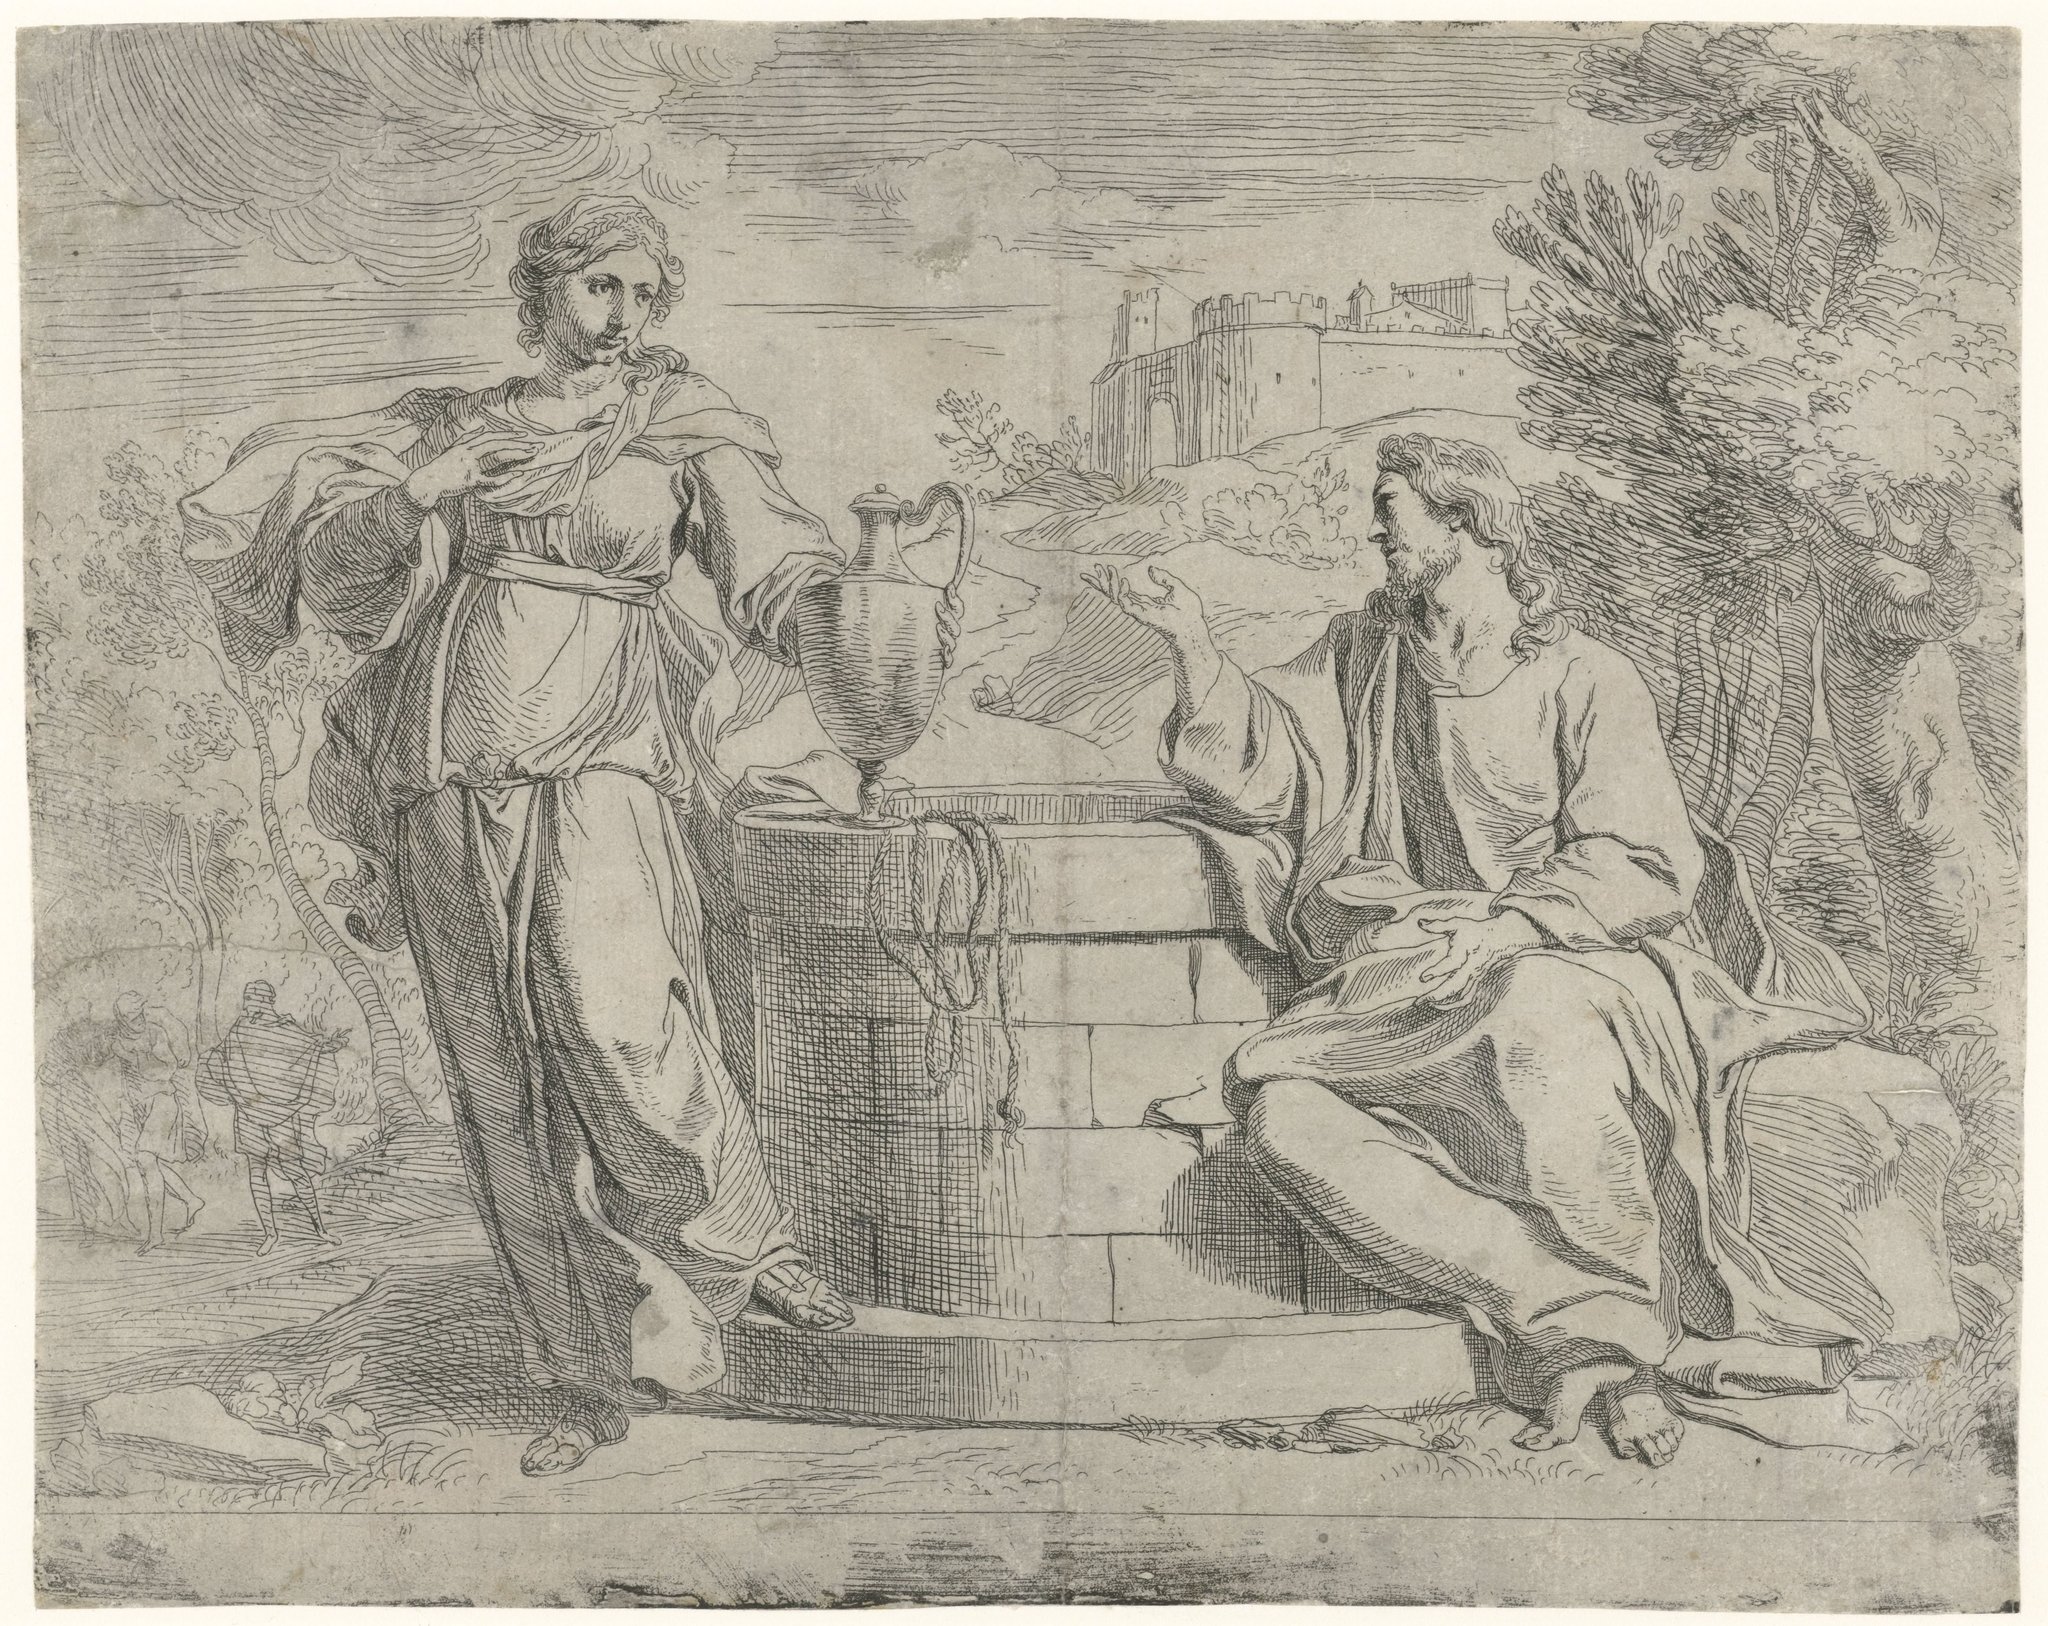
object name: print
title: Christus en de Samaritaanse vrouw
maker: francesco albani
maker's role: draughtsman, painter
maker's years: 1578-1660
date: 1618-1646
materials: paper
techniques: etching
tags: christ and the woman of samaria: sitting at jacob's well he asks her for a drink from her jug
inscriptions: collector's mark: Lugt 240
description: Christus zit op de rand van een waterput. De Samaritaanse vrouw biedt hem te drinken aan uit haar waterkan. Op de achtergrond komen enkele discipelen aanlopen.